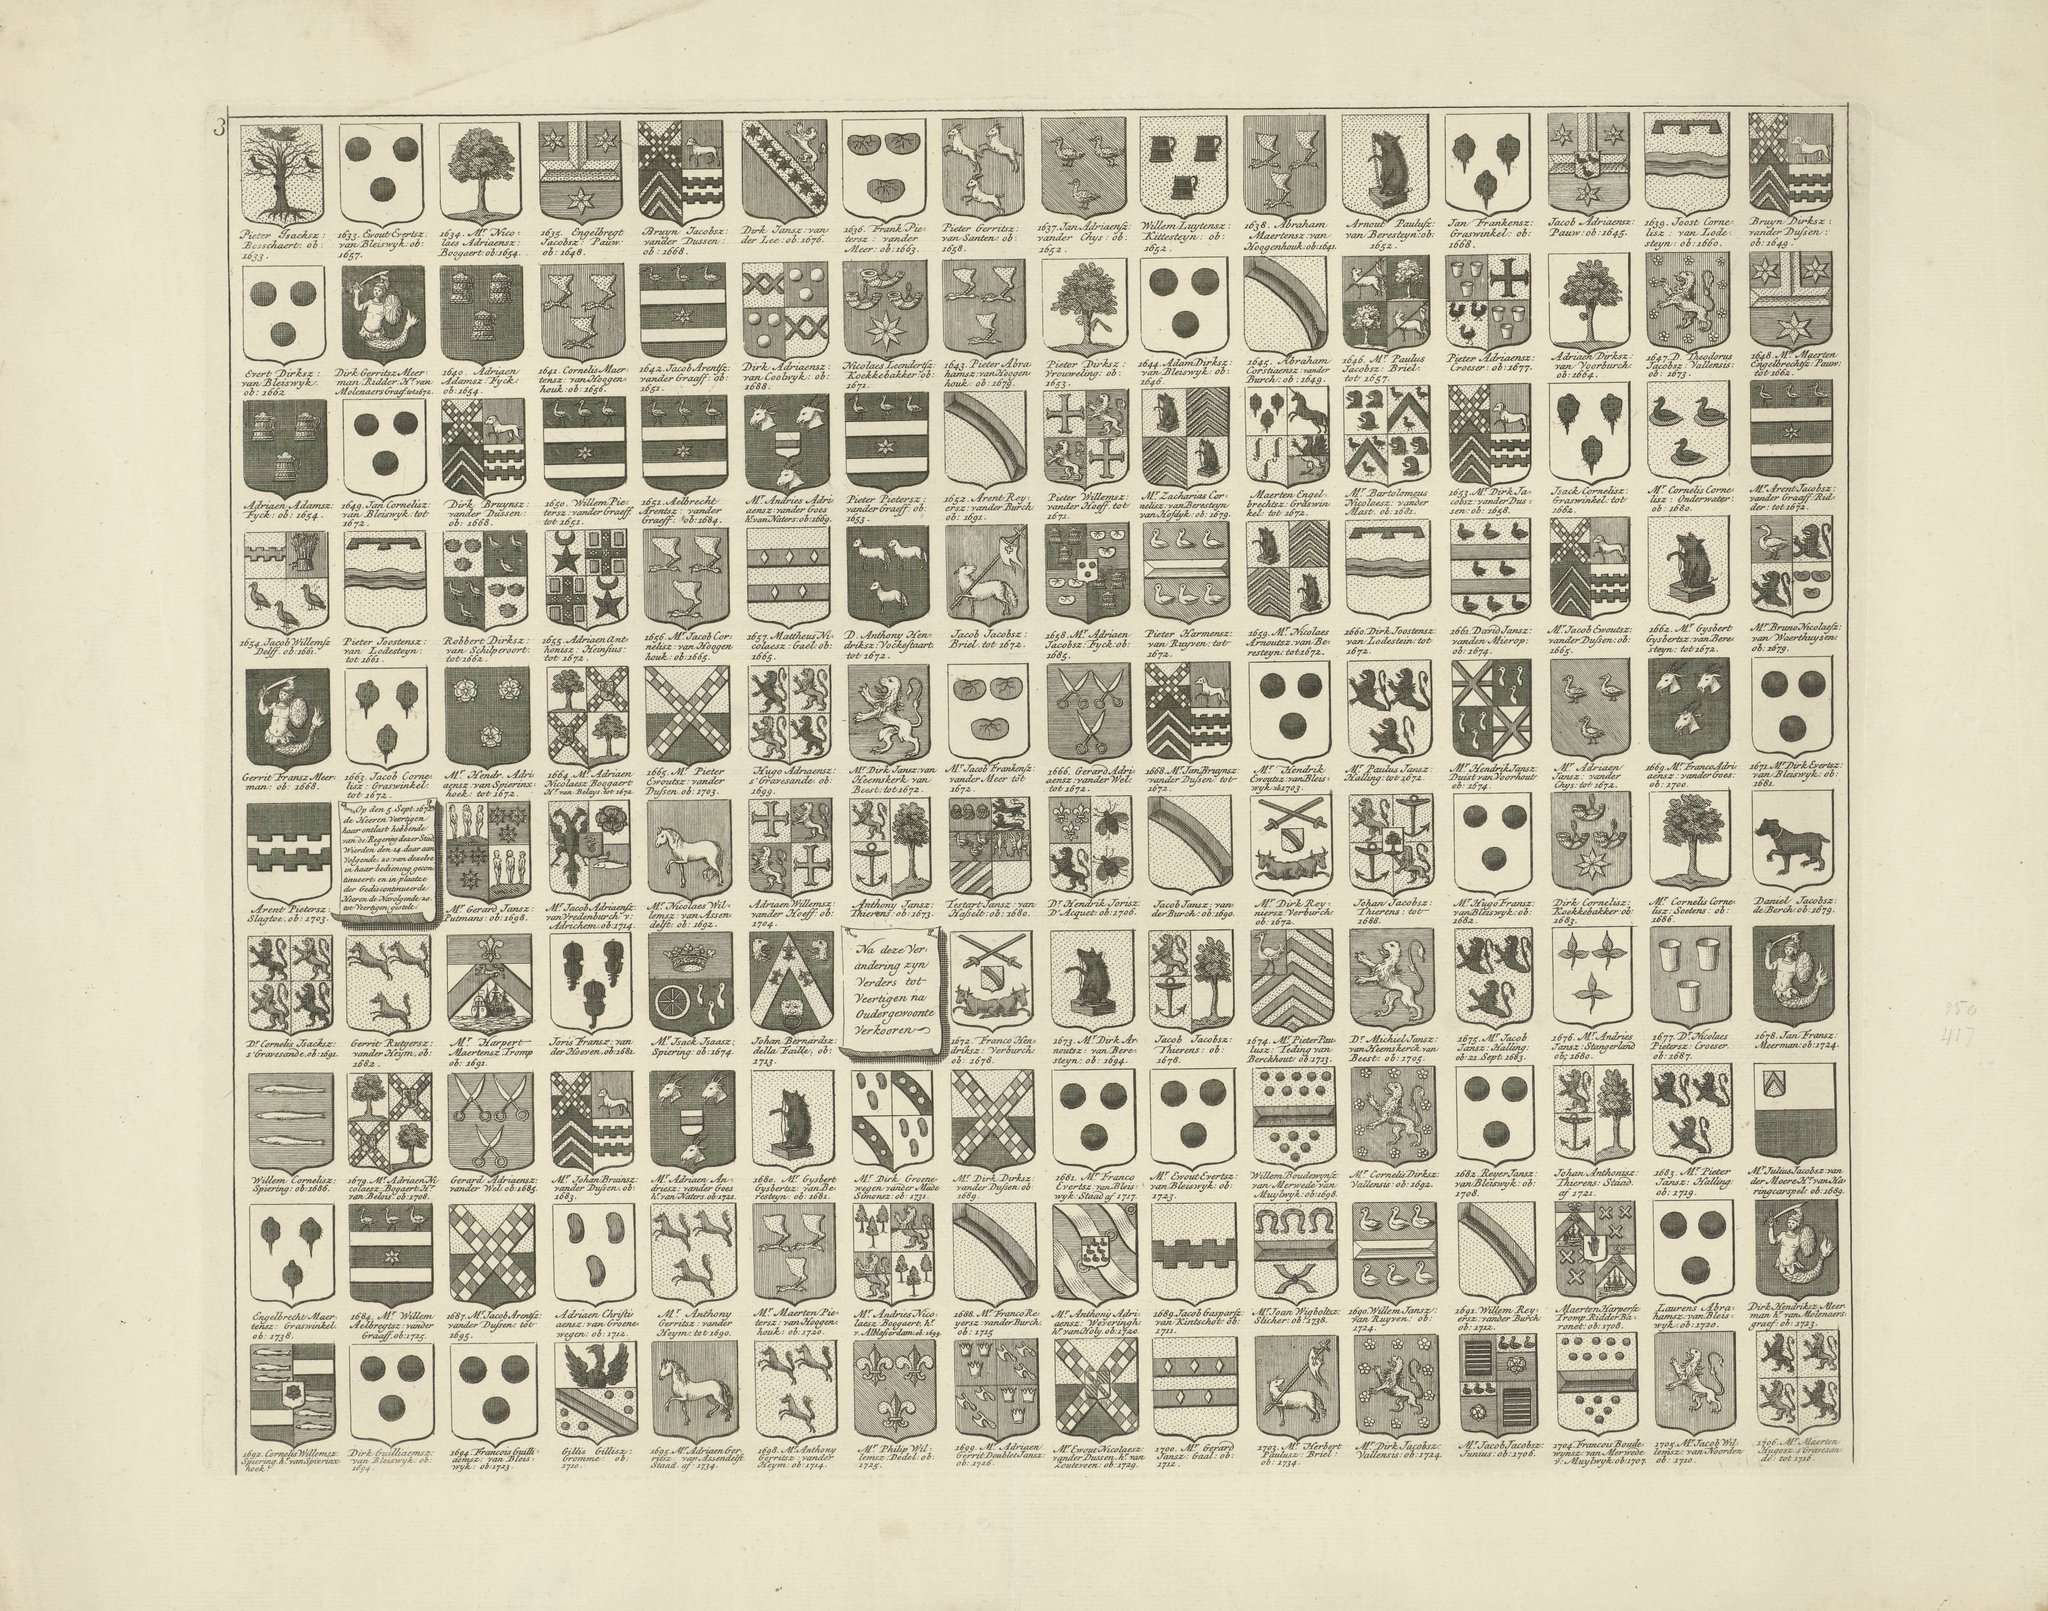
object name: print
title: Namen ende Wapenen der Ed: Agtbaare Heeren Veertigh Raaden der Stad Delft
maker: hendrik de leth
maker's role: draughtsman, print maker, publisher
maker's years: 1703-1766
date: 1738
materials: paper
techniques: etching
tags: armorial bearing, heraldry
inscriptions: collector's mark: Lugt 2228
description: Wapenkaart met de wapens en namen van de Heren Veertigen van Delft. Prent linksboven genummerd: 3. De prent maakt deel uit van een vierdelige (oorspronkelijk mogelijk vijfdelige) serie prenten gewijd aan de Heren Veertigen van Delft.